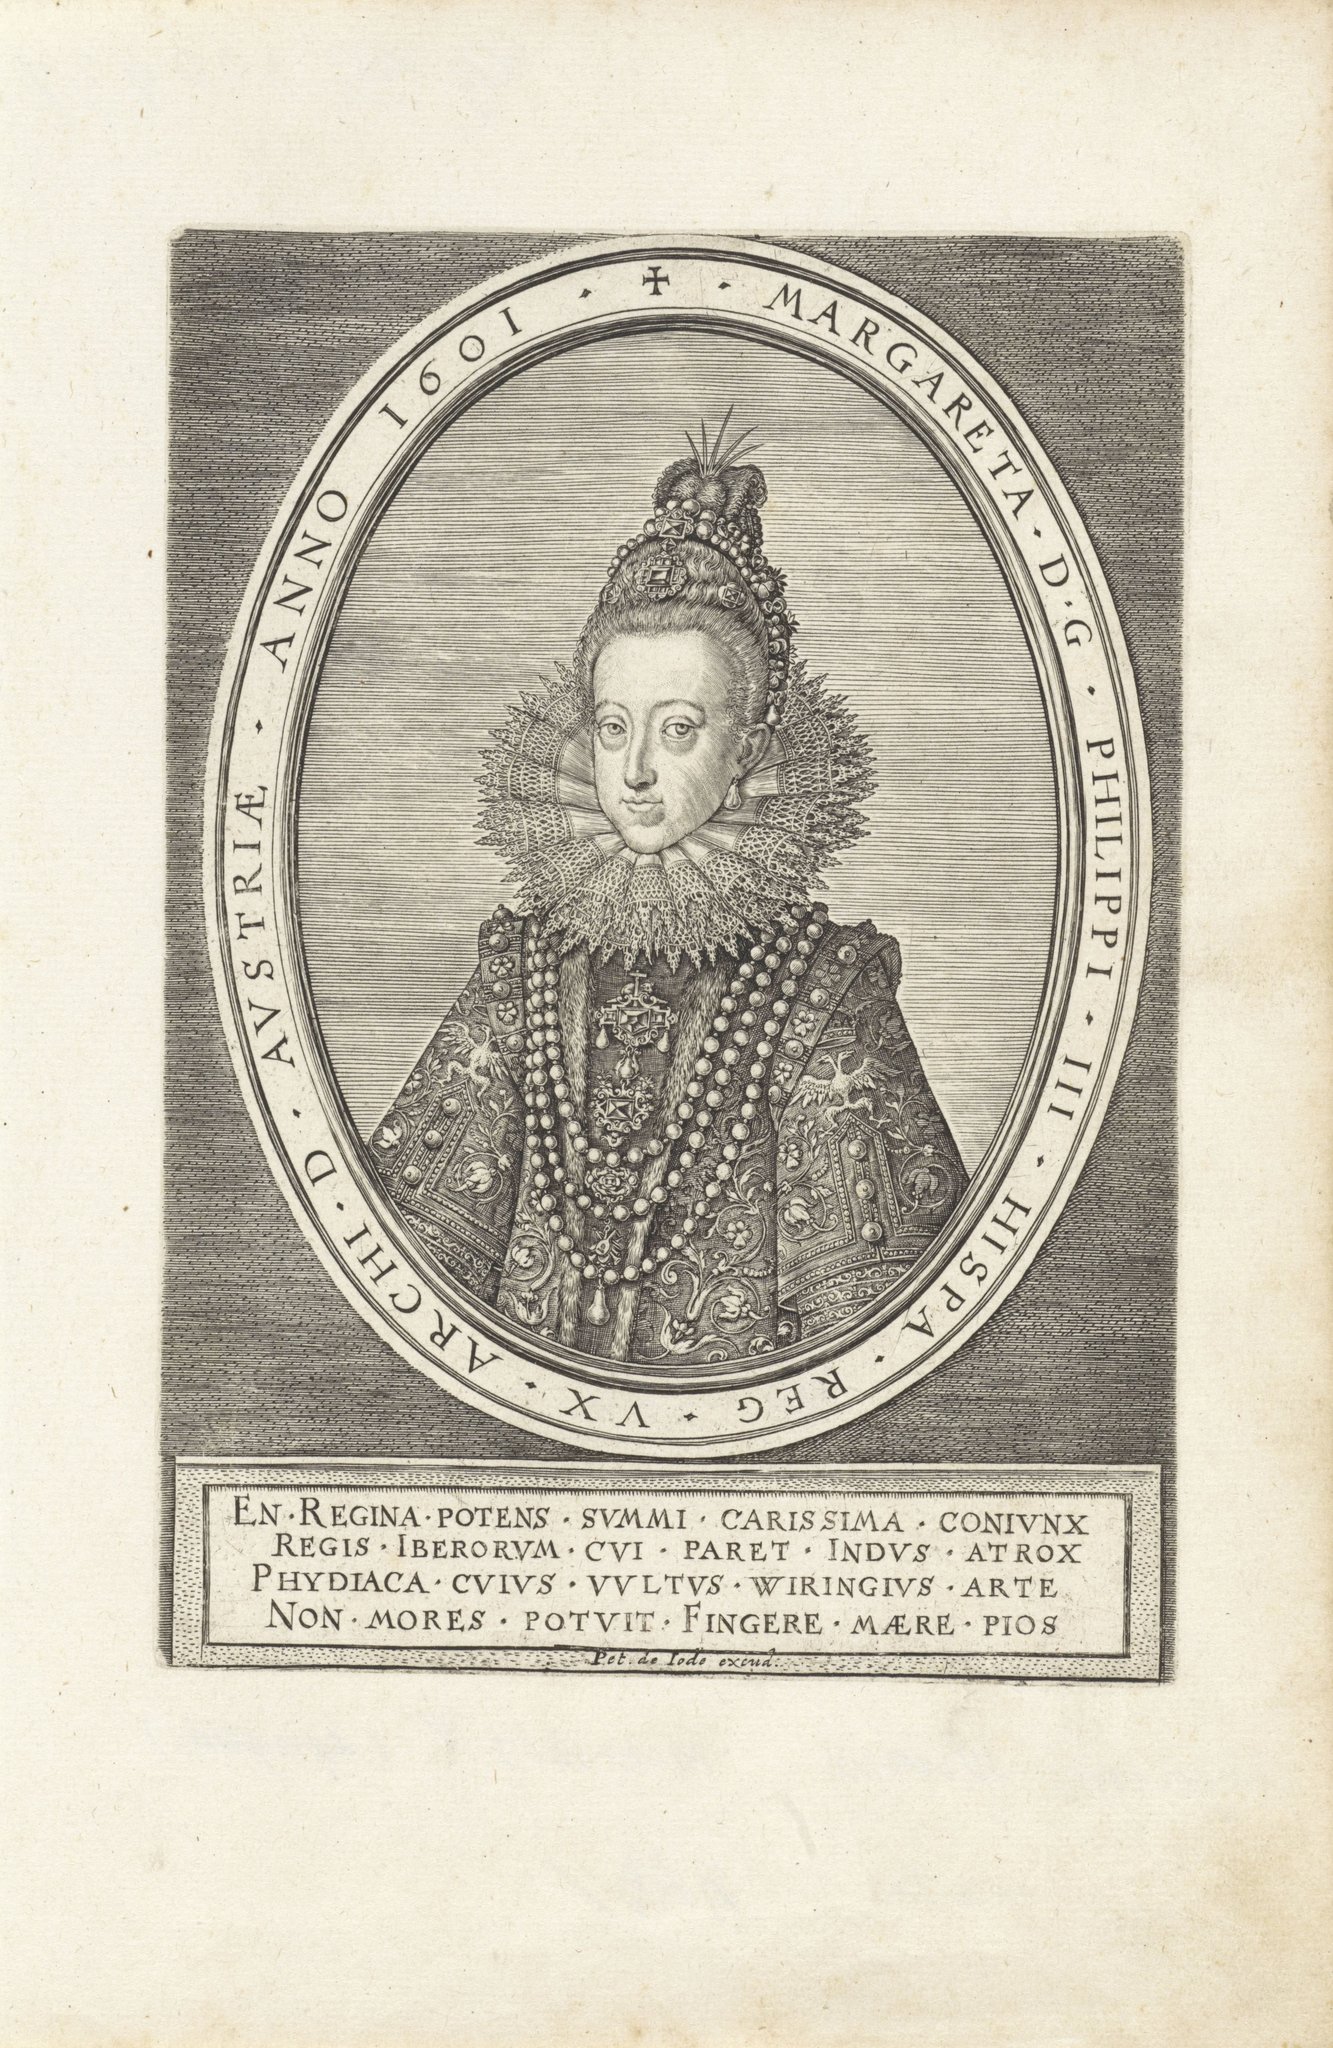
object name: print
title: Portret Margaretha van Oostenrijk, koningin van Spanje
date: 1601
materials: paper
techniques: engraving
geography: antwerp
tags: margaretha van oostenrijk (koningin van spanje), pearl; pearl necklace (+ women's clothes)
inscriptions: collector's mark: Lugt 2760, collector's mark: Lugt 2228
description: Portret Margaretha van Oostenrijk, koningin van Spanje. In het kader een vierregelig onderschrift in het Latijn.